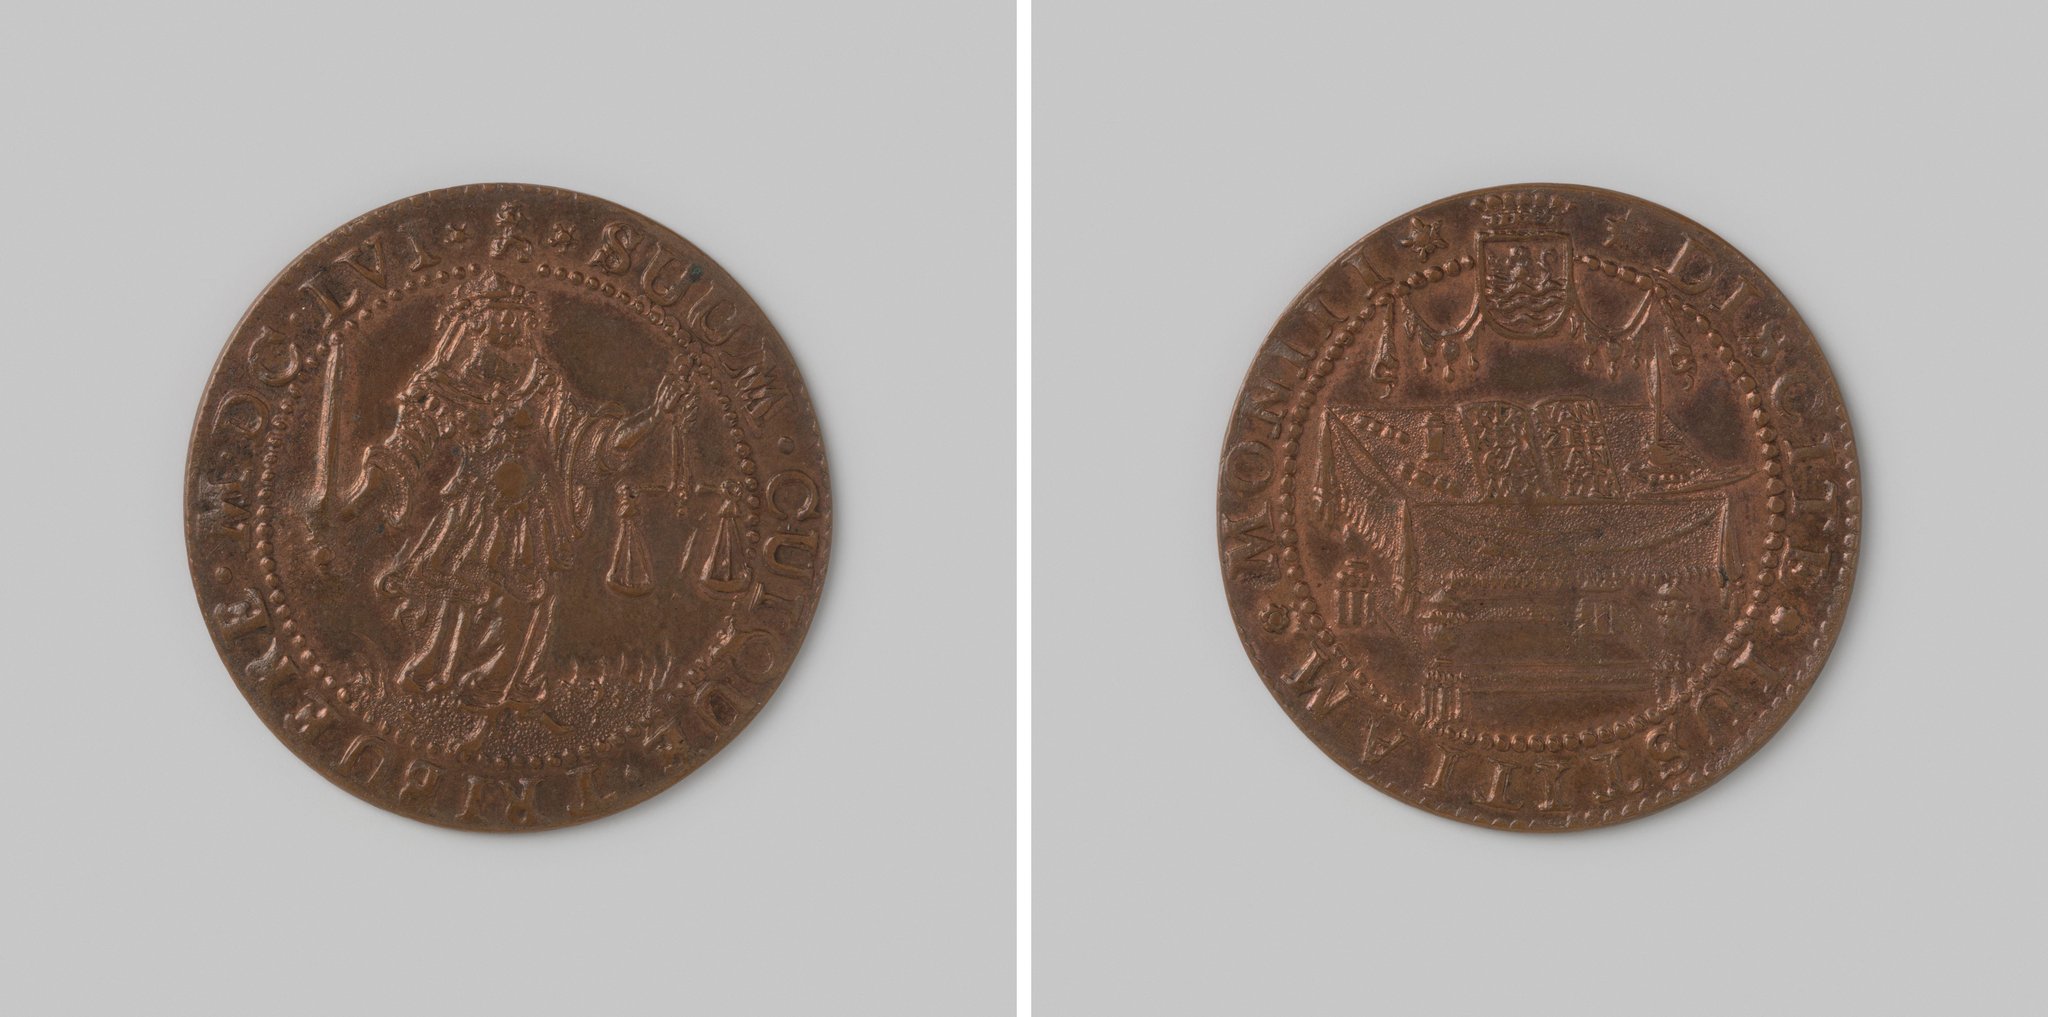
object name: jeton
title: Rekenpenning uit Middelburg voor de Rekenkamer van Zeeland 1656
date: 1656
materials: copper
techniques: striking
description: Koperen penning, op de voorzijde Justitia met zwaard en weegschaal, met omschrift, op de keerzijde een tafel met een busje met twee rijen rekenpenningen, een opengeslagen boek en een inktpot met veer, onder een guirlande met het wapenschild van Zeland, met omschrift.